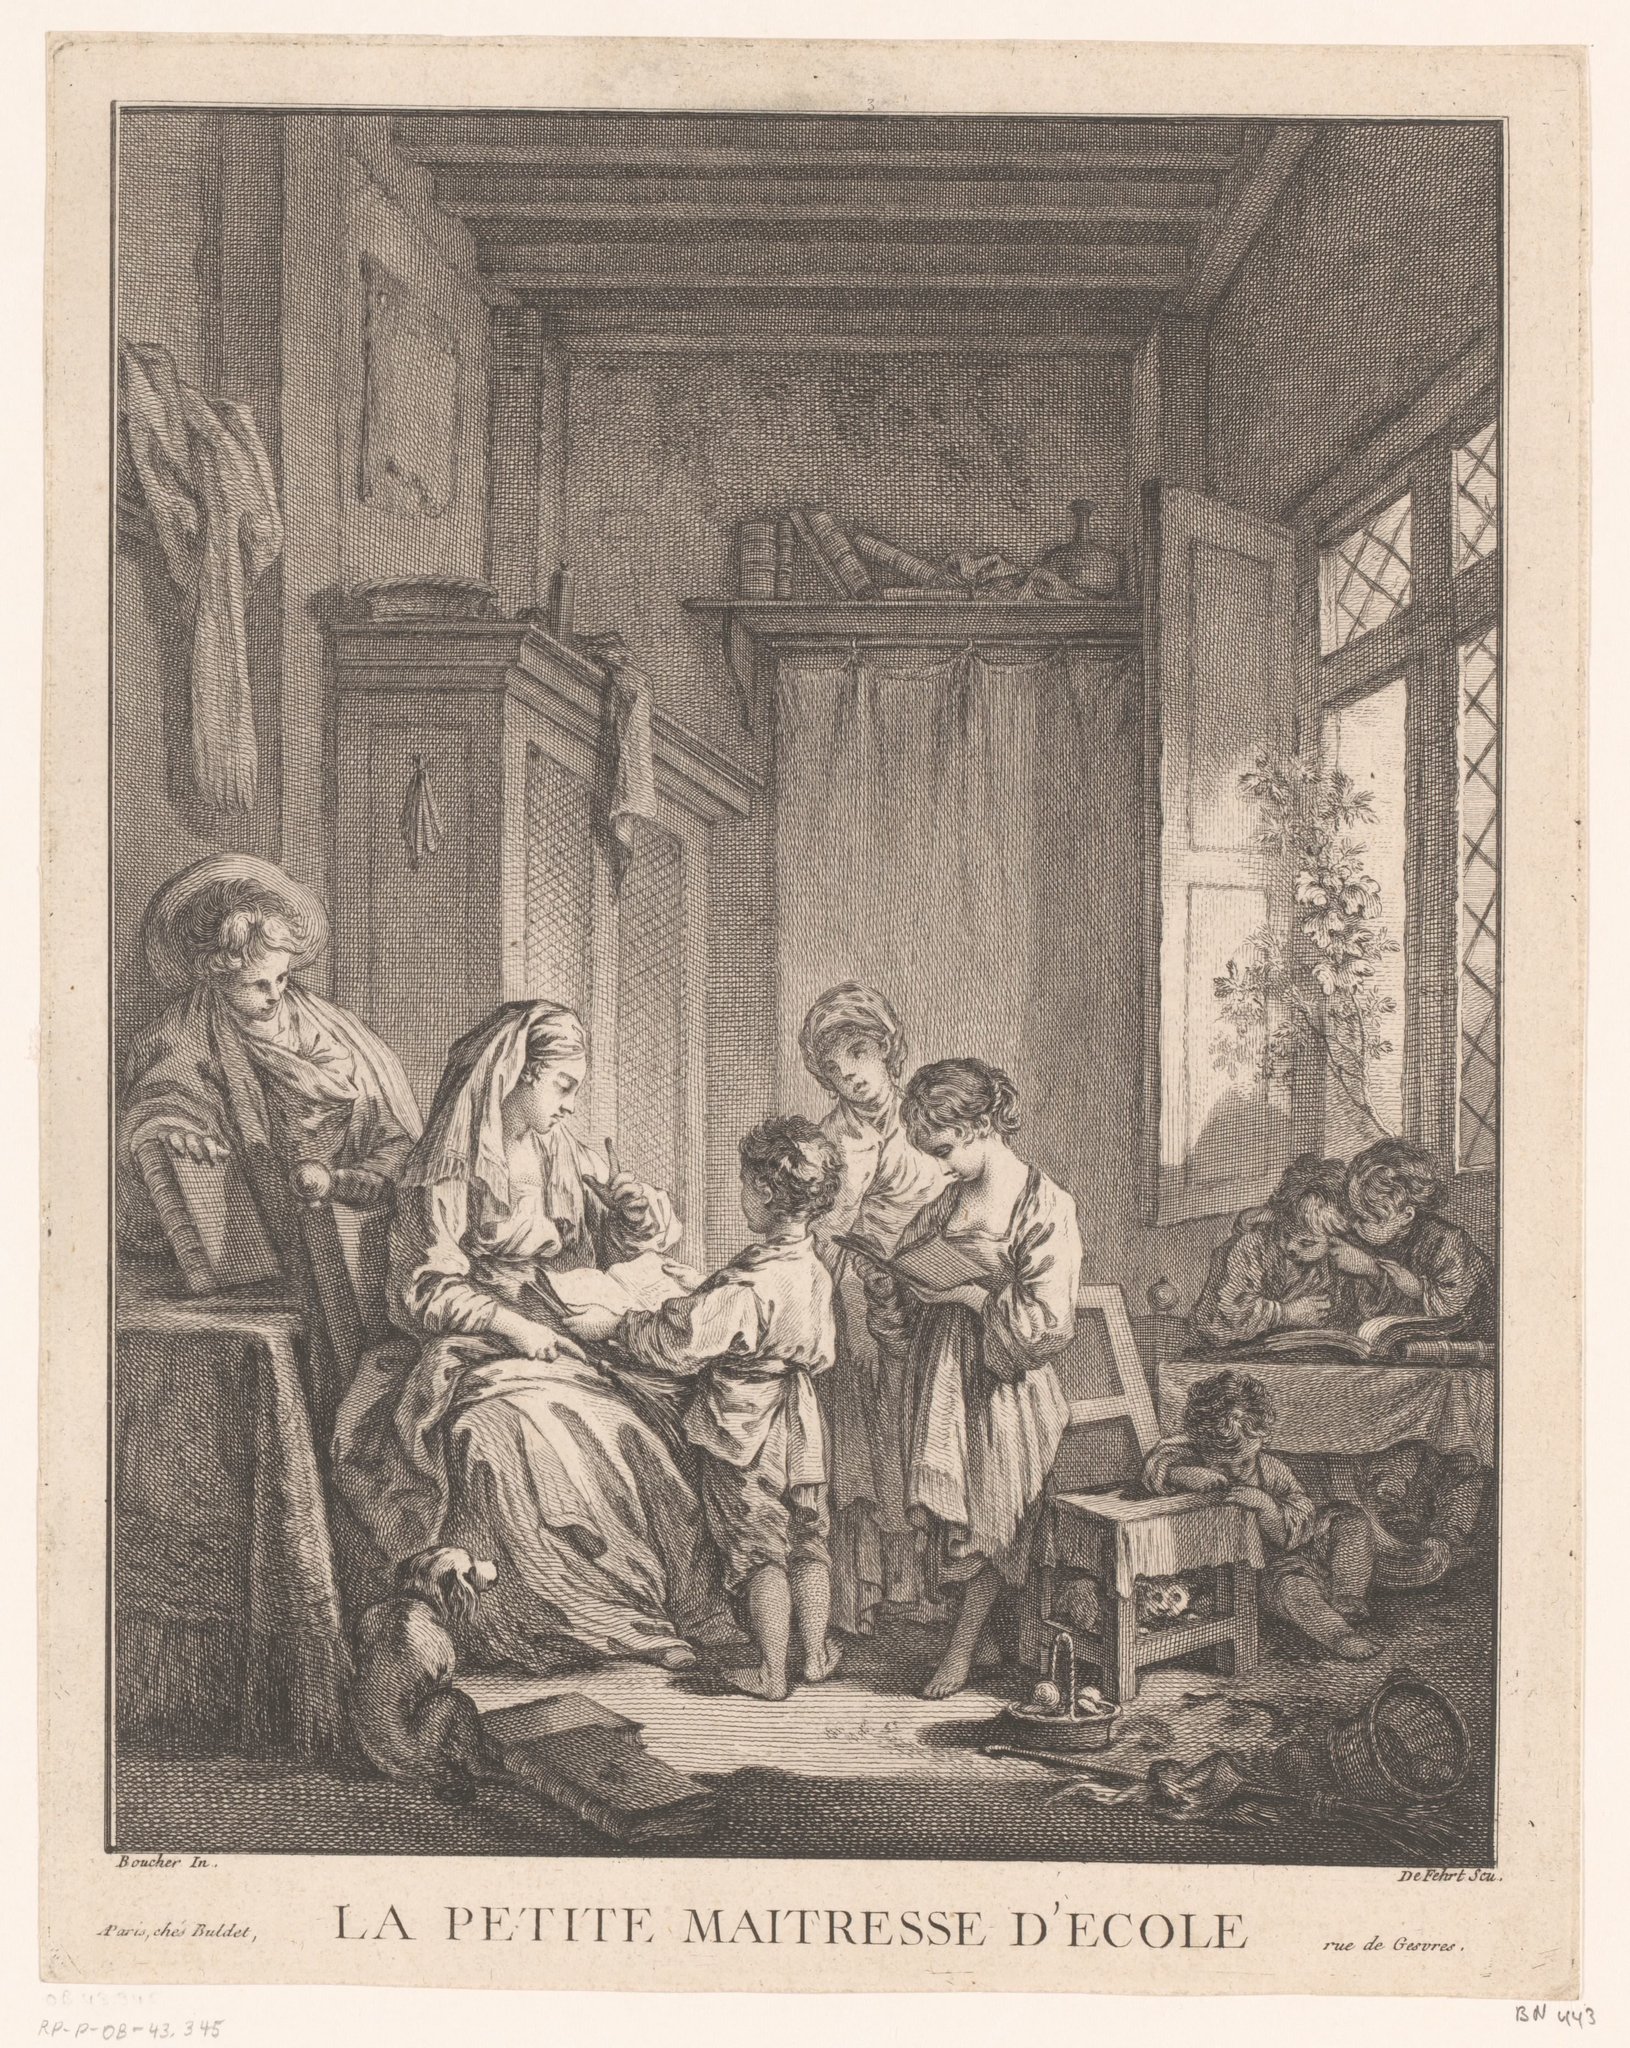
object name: print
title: Onderwijzeres met kinderen in de klas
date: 1734-1774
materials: paper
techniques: engraving, etching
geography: paris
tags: teacher and pupil, open window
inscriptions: collector's mark: Lugt 2760, collector's mark: Lugt 2228